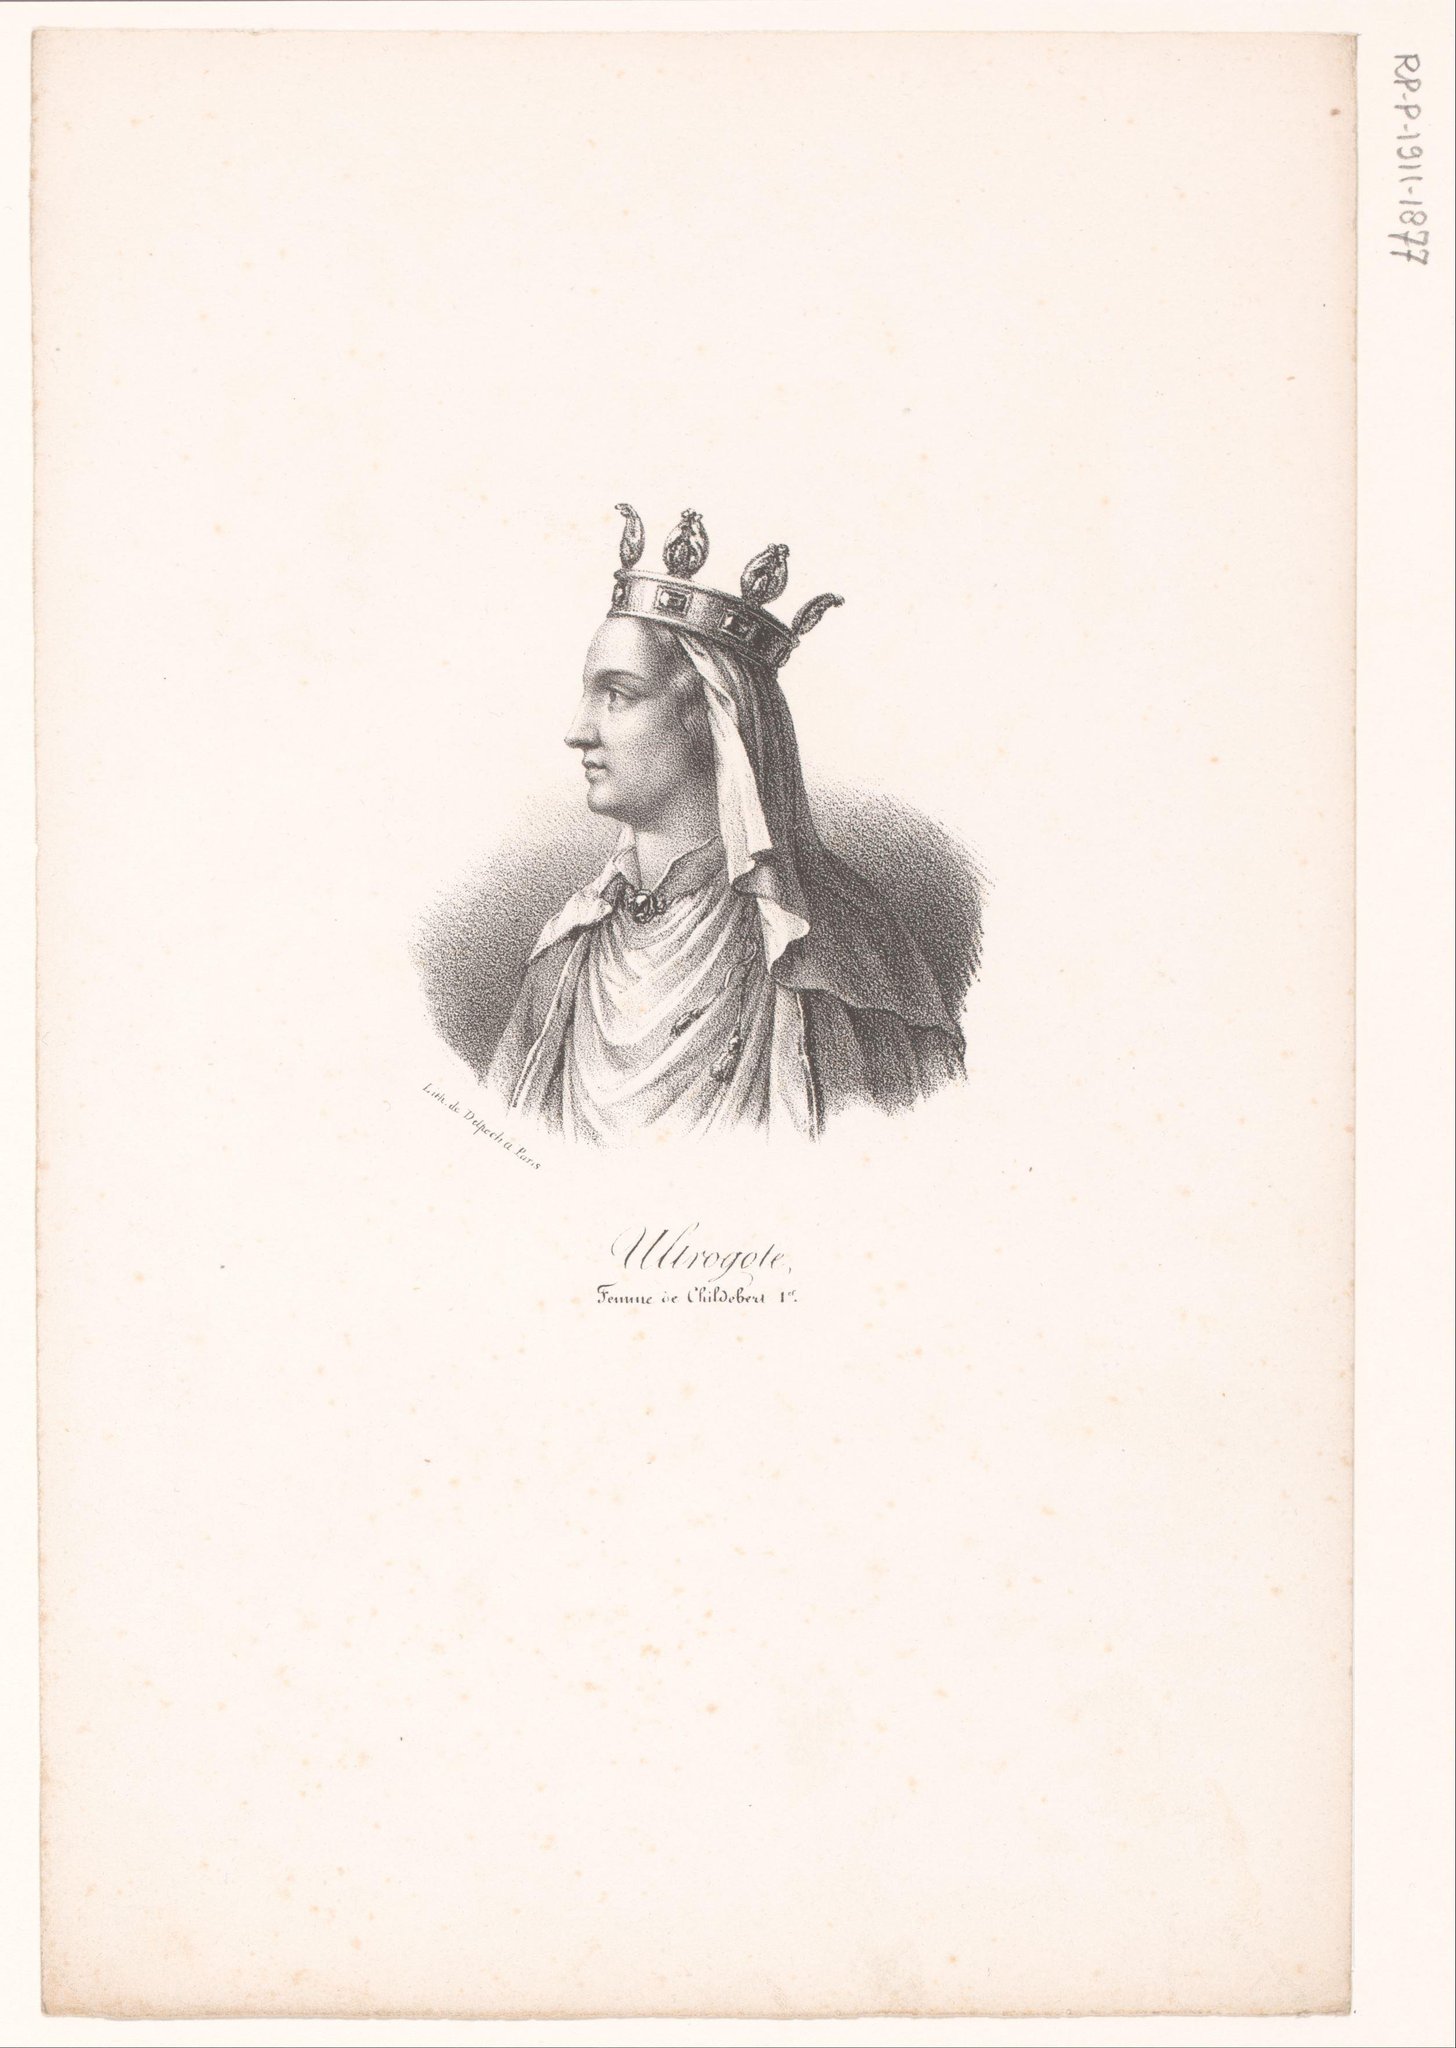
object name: print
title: Portret van koningin Ultragotha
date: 1818-1842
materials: paper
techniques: lithograph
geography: paris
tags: historical persons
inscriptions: collector's mark: Lugt 2228a